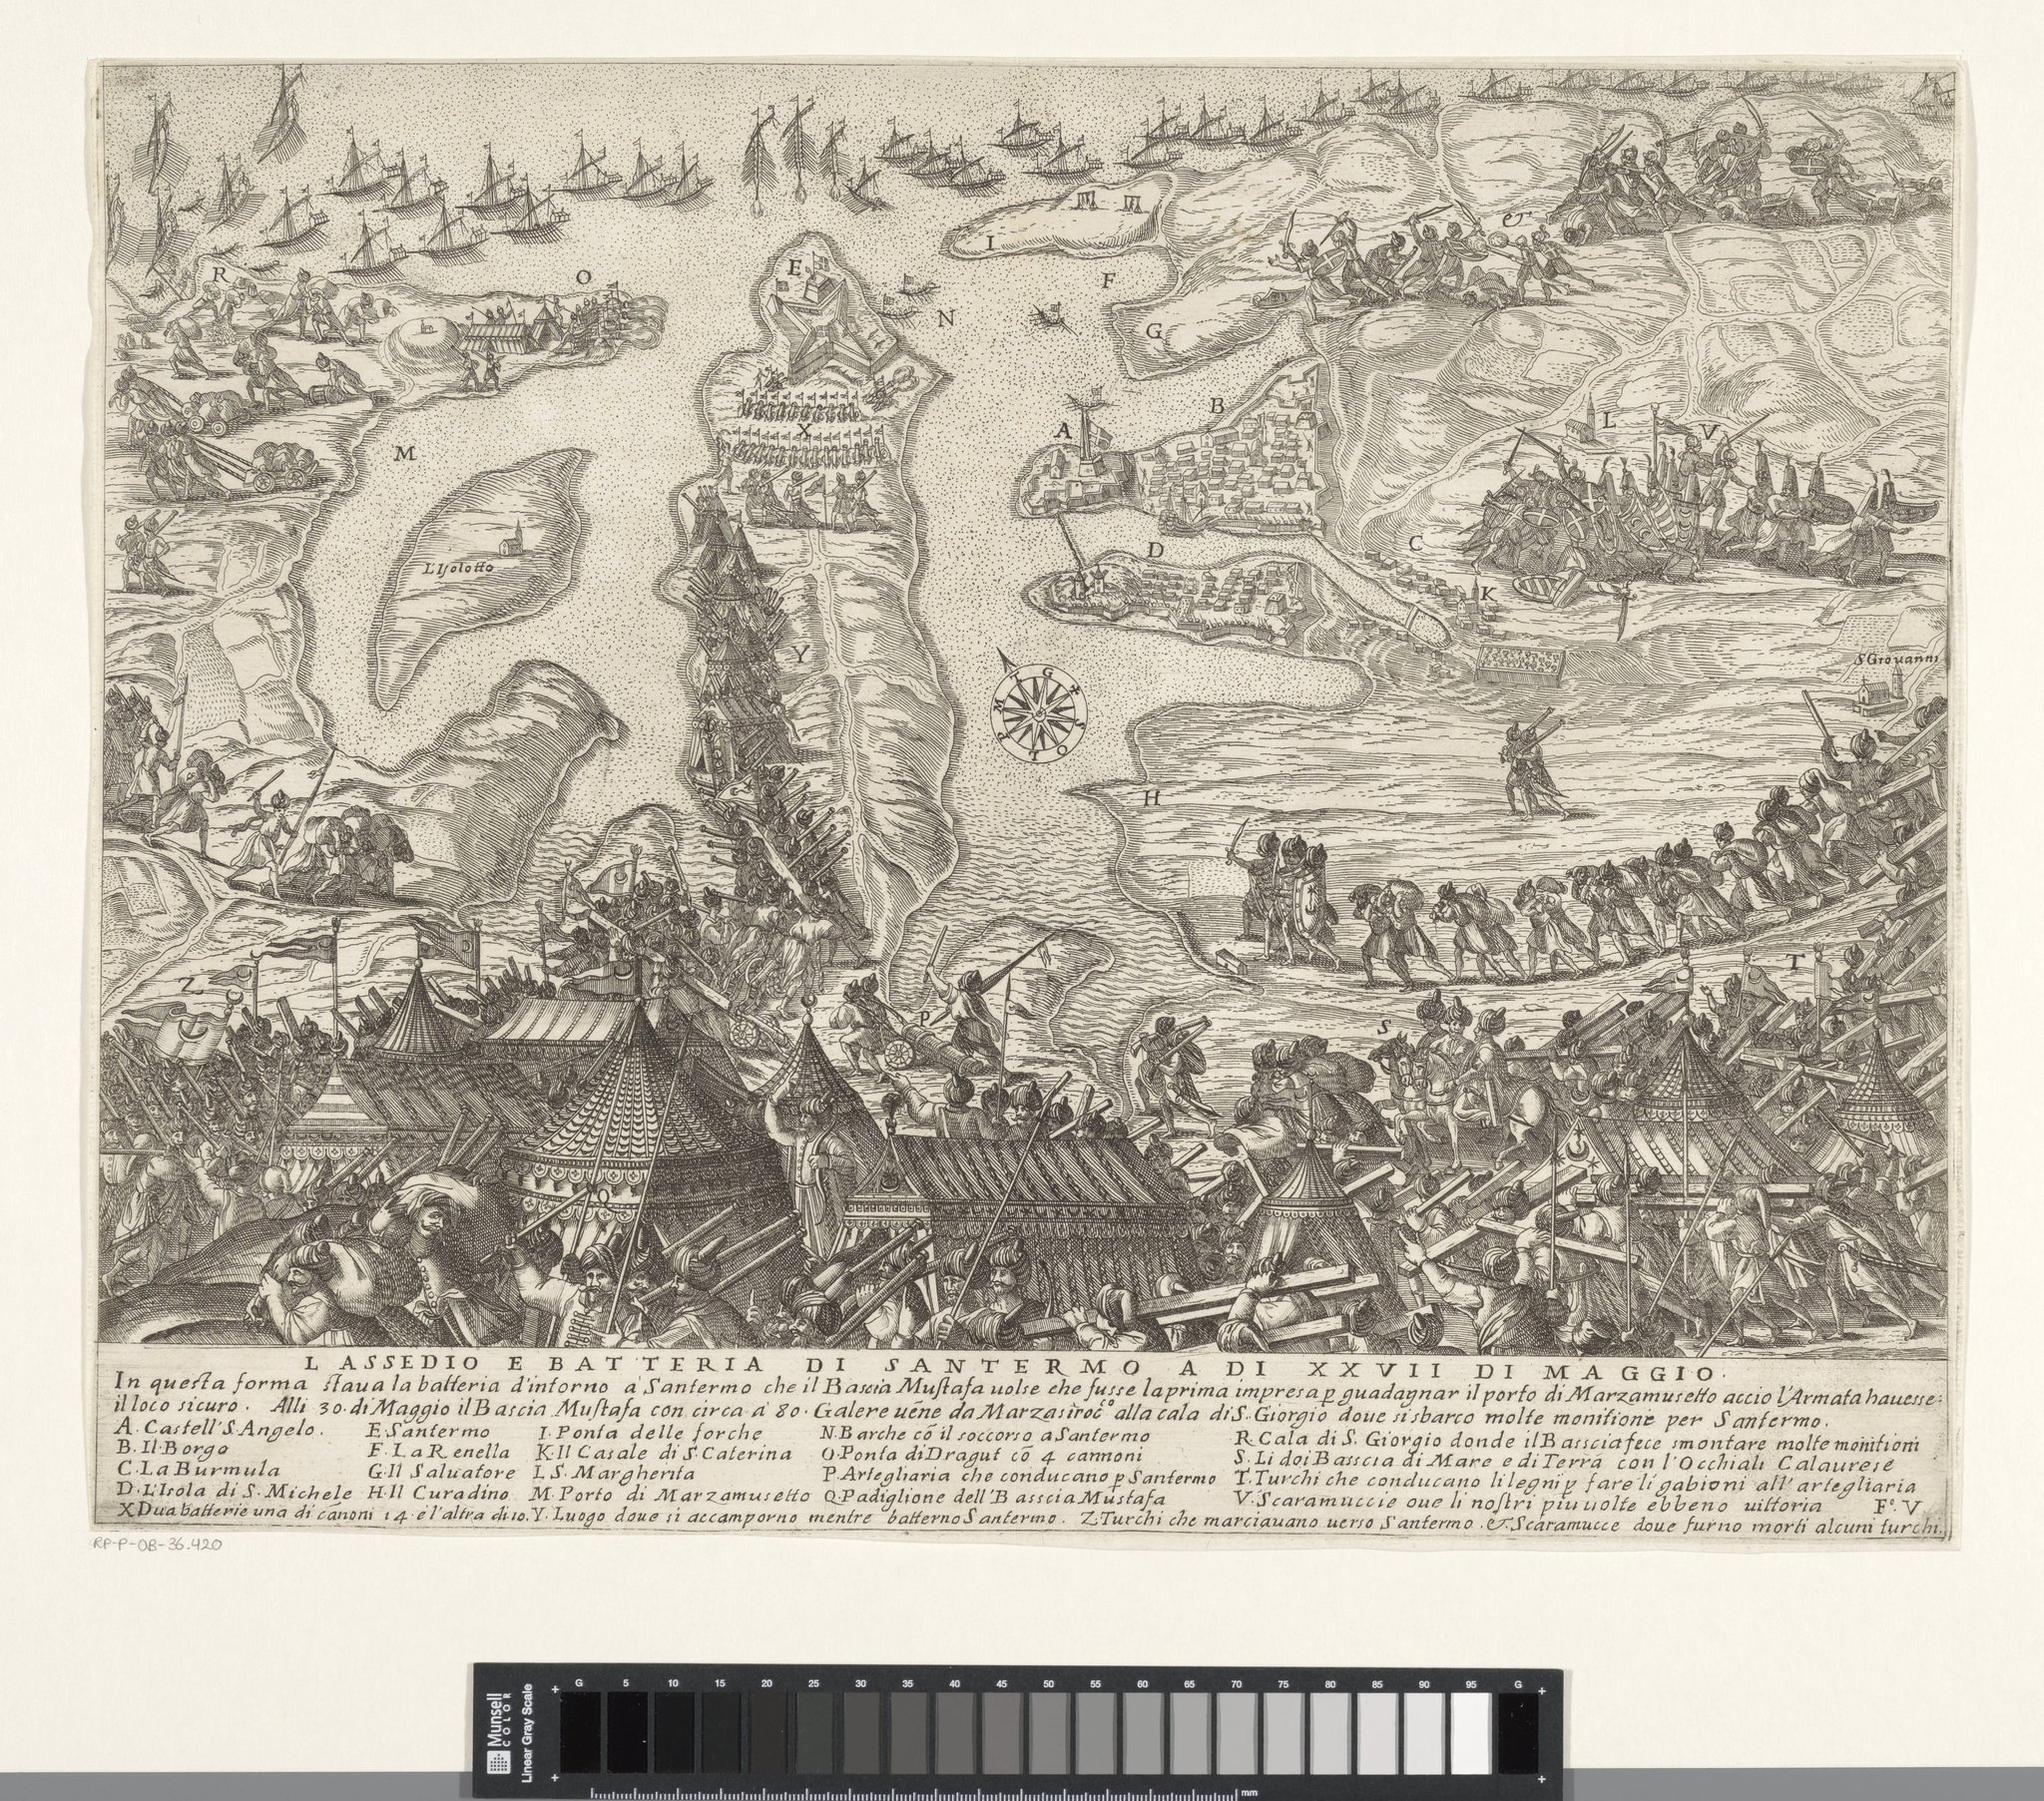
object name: print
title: De belegering van Malta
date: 1665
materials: paper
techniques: etching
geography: italy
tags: island, asiatic races and peoples: turks, the soldier; the soldier's life, battle (+ land forces)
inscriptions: collector's mark: Lugt 2228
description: Het beleg van Santeremo op Malta. Op de voorgrond Turkse soldaten rond een tentenkamp op Malta. Op de achtergrond strijdende soldaten. Italiaanse verklarende lijst met nummers in ondermarge. Genummerd rechtsonder: Fo. V.